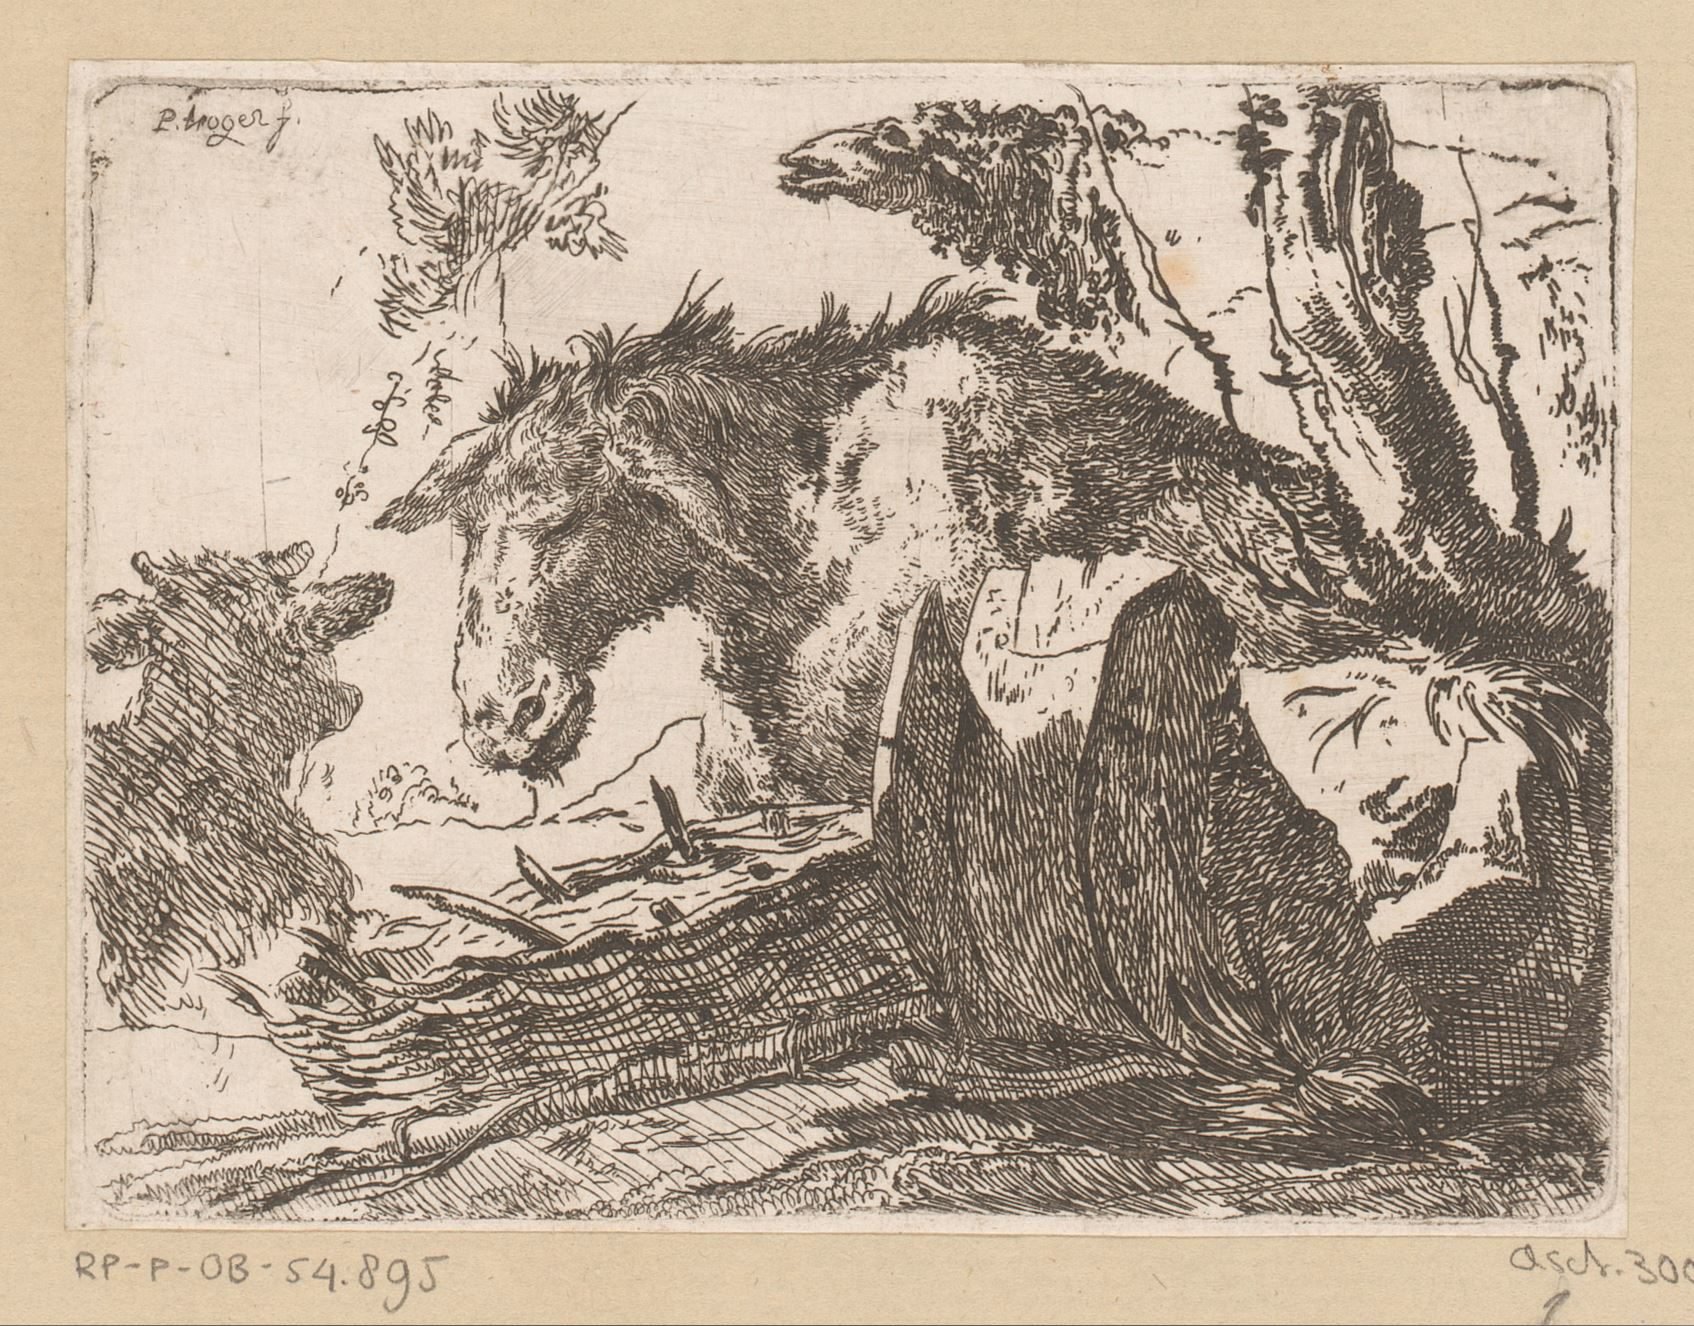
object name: print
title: Rustende ezel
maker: paul troger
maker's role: print maker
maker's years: 1698-1762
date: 1708-1762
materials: paper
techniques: drypoint, etching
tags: ass, donkey, container made of plant material other than wood: basket, sheep, bovine cattle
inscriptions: collector's mark: Lugt 240